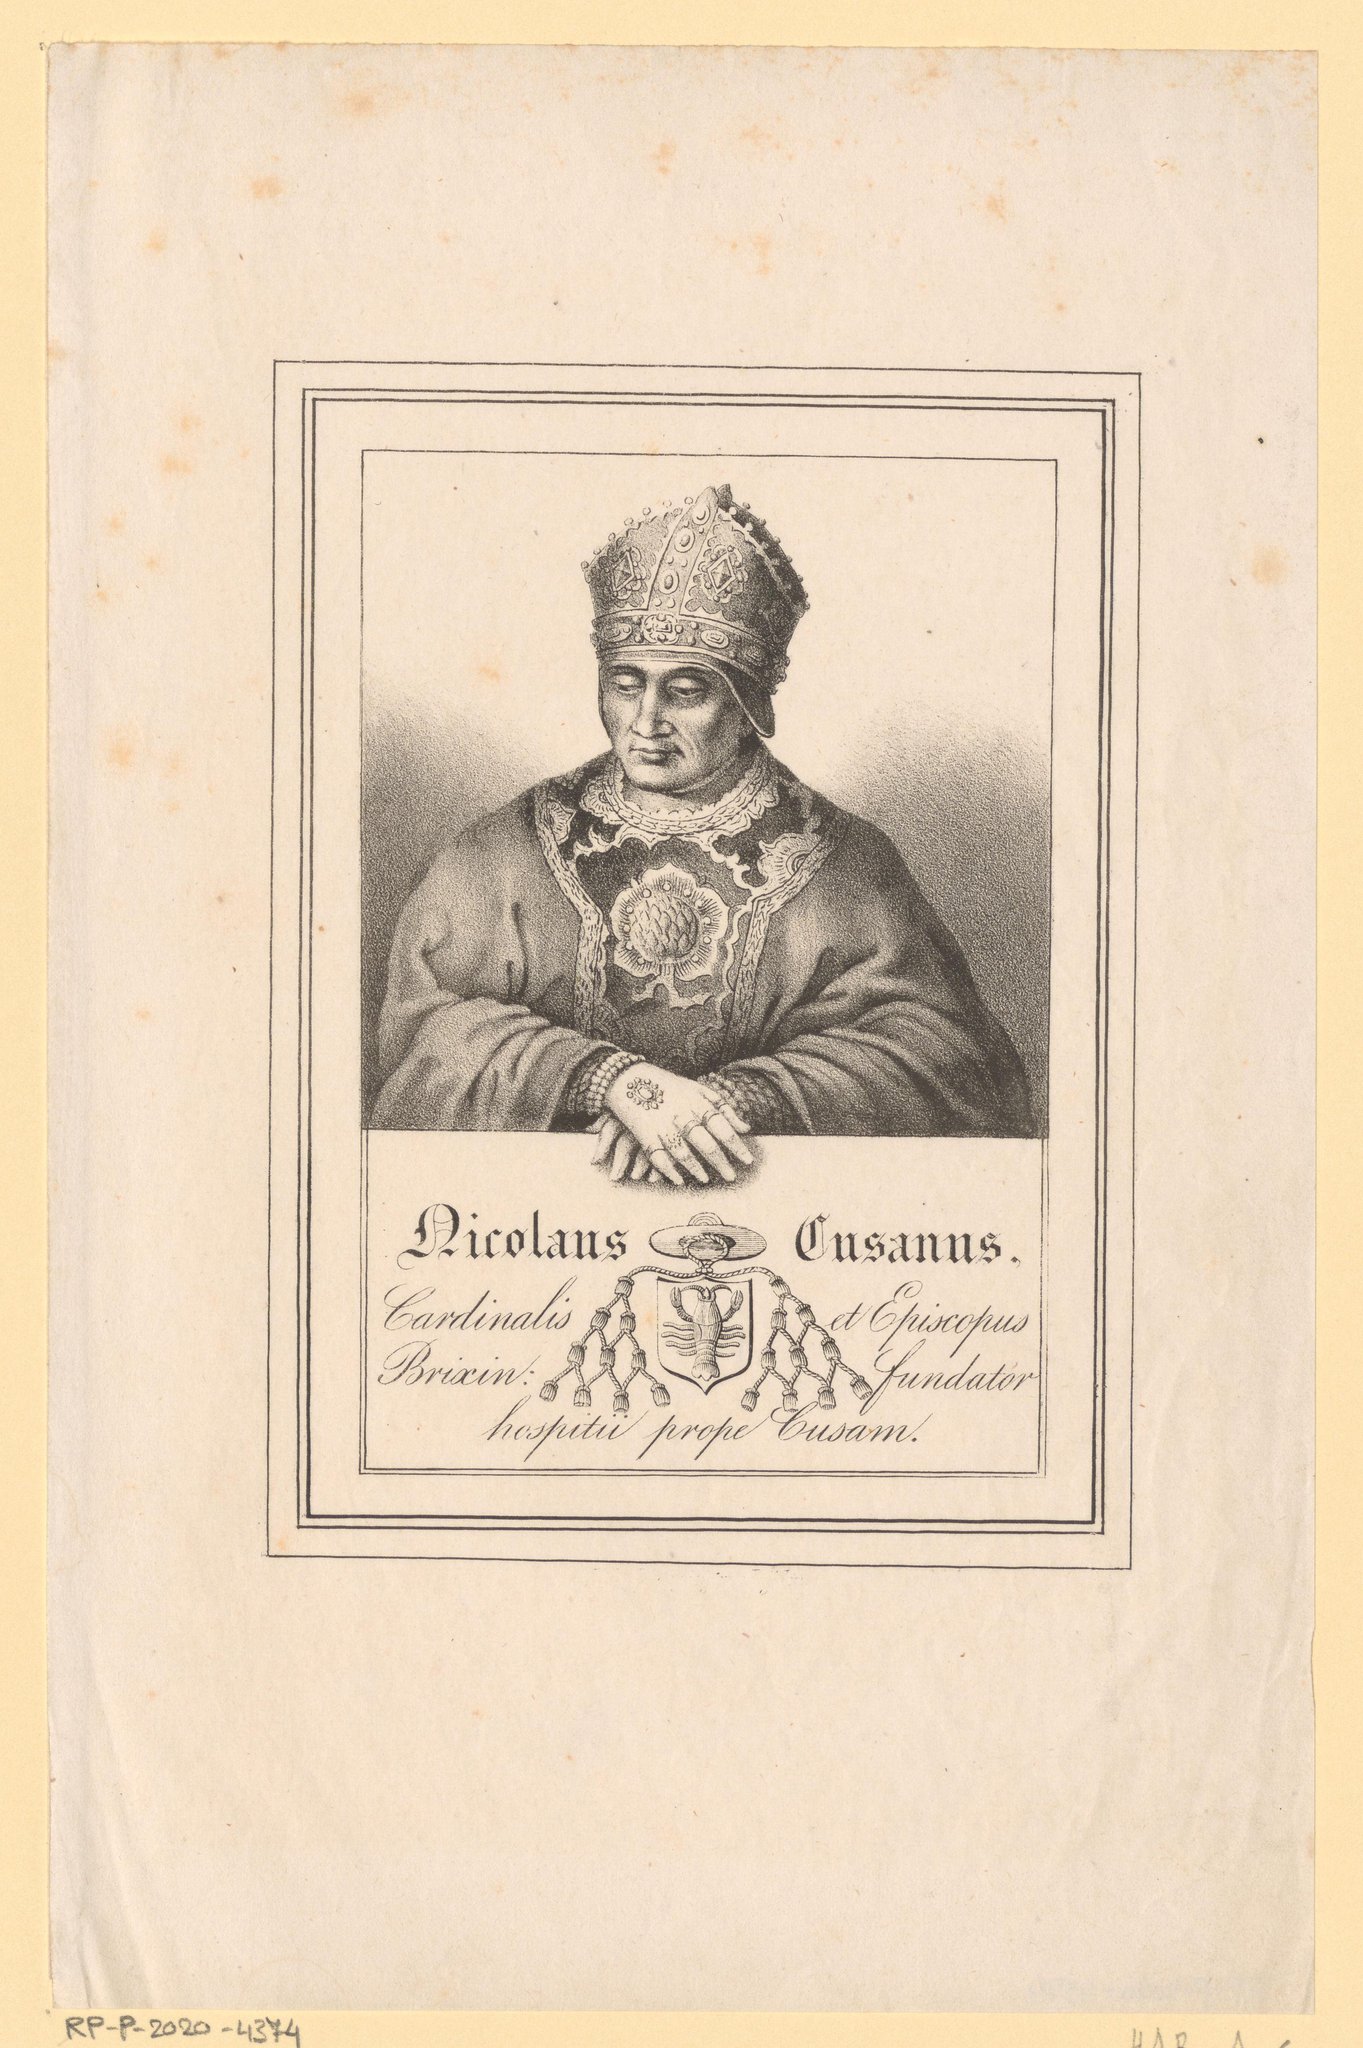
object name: print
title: Portret van Nicolaas van Cusa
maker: Anonymous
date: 1798-1899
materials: paper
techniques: lithograph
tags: historical persons